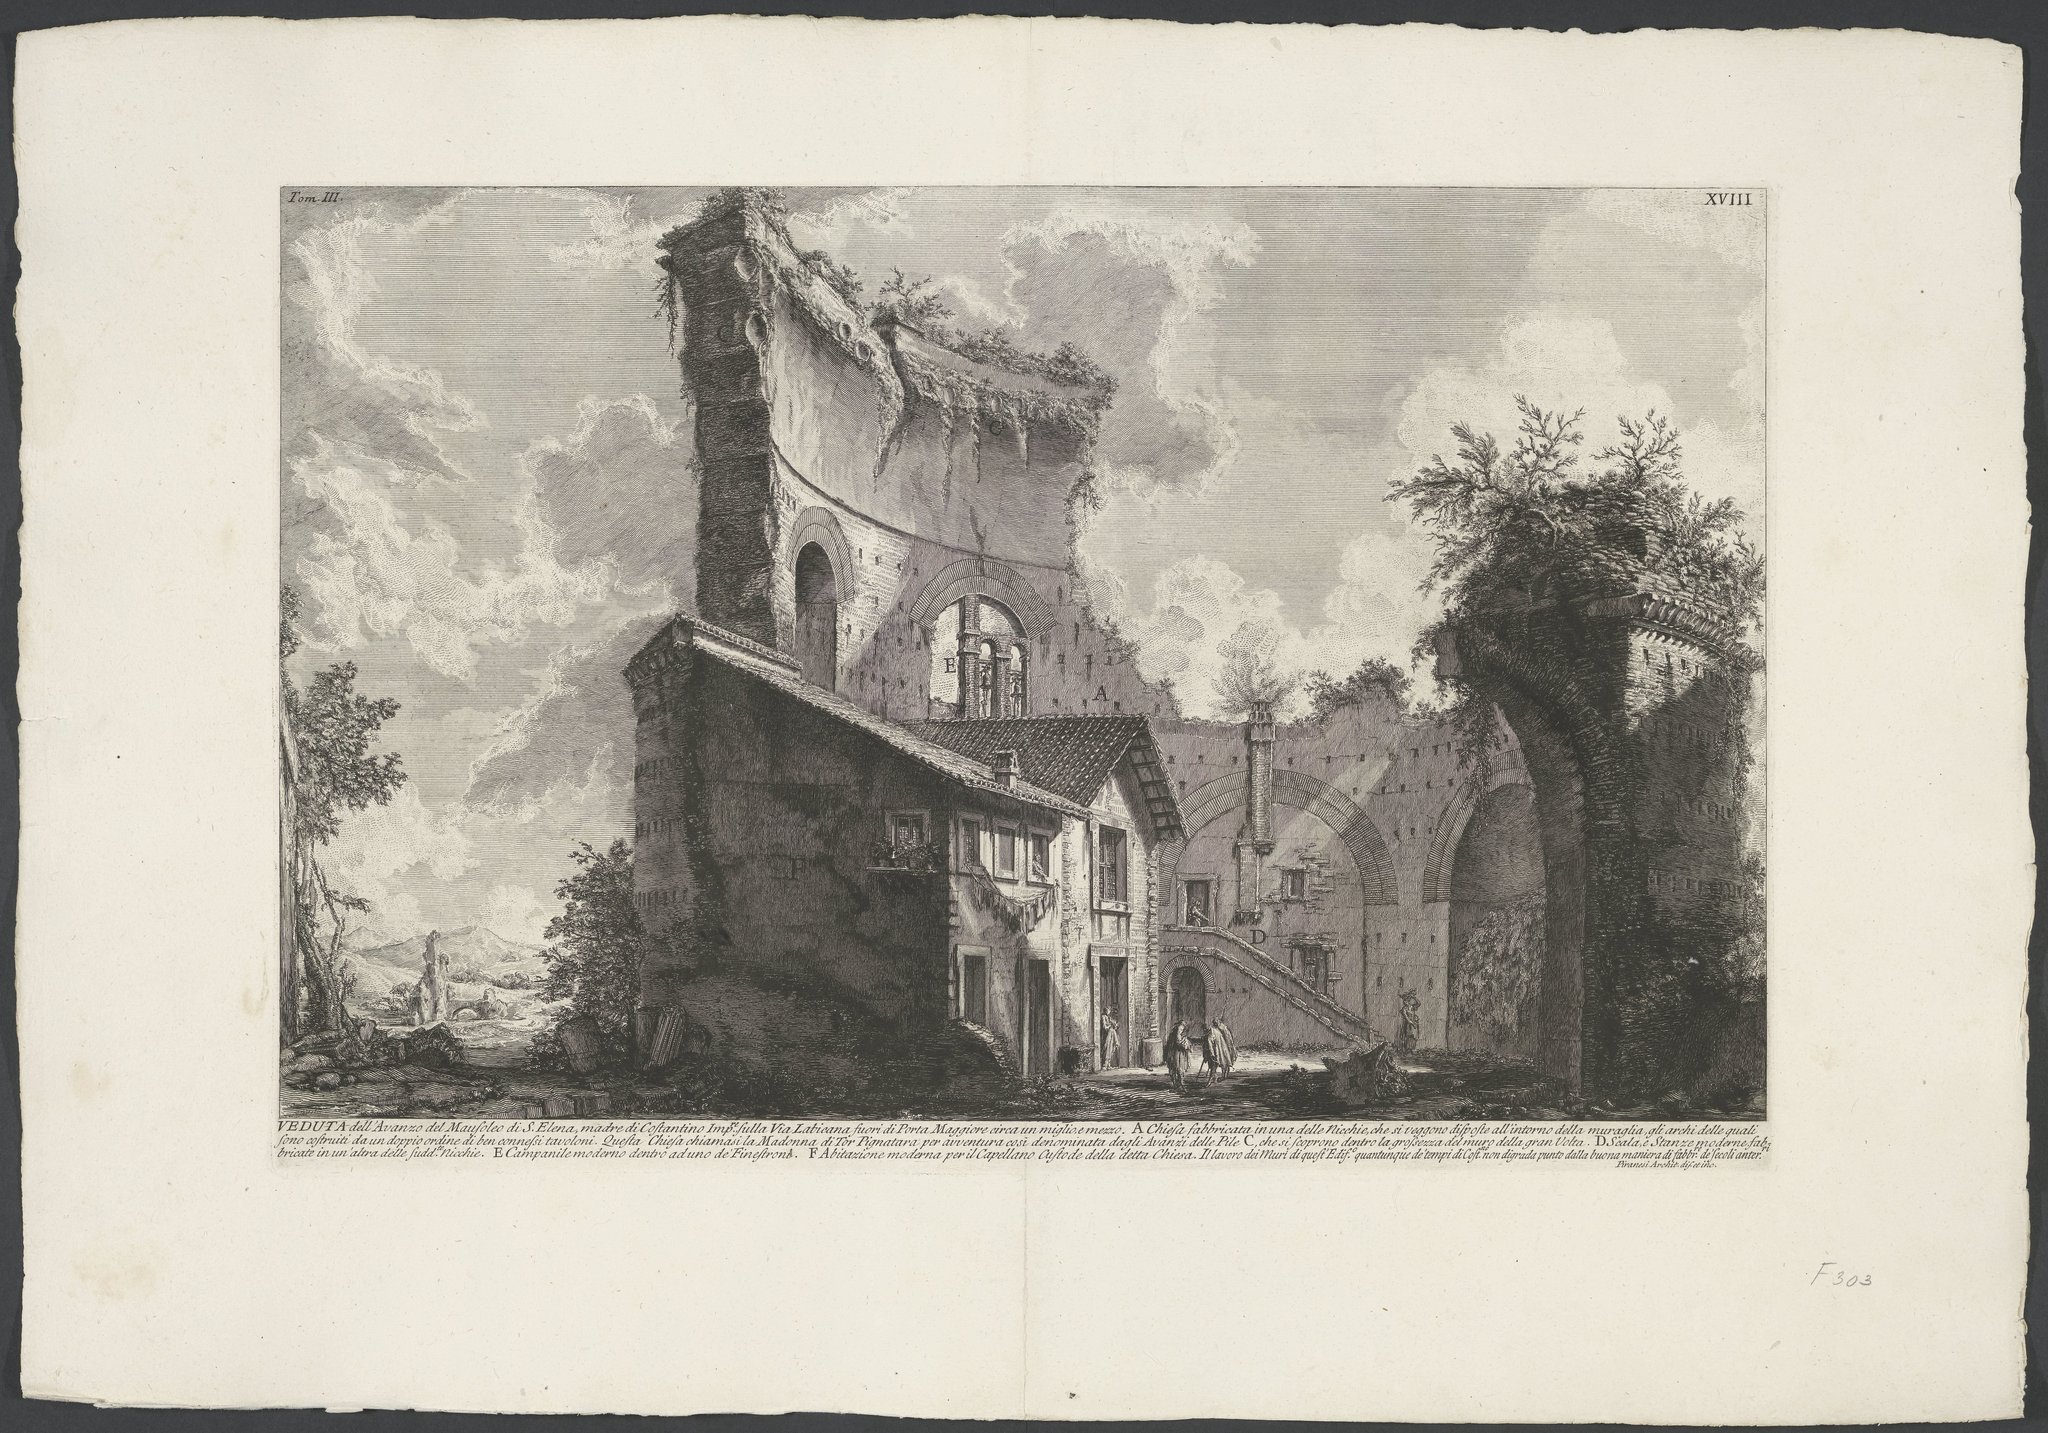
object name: print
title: Archeologische vondsten in en rond Rome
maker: giovanni battista piranesi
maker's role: designer, draughtsman, print maker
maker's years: 1720-1778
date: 1756-1757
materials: paper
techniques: etching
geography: rome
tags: ruin of a building ~ architecture, landscape with ruins, grave, tomb, mausoleum, rome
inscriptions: collector's mark: Lugt 2228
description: Deze prent maakt deel uit van de serie 'Le Antichità Romane'. Piranesi deed meer dan acht jaar voorstudie voor deze 250 platen tellende serie die in vier volumes werd uitgegeven. Hij produceerde de prenten tussen ca. 1756 en 1757. De serie bevat ook prenten door of naar andere prentmakers, onder wie Francesco Bianchini en Girolamo Rossi.